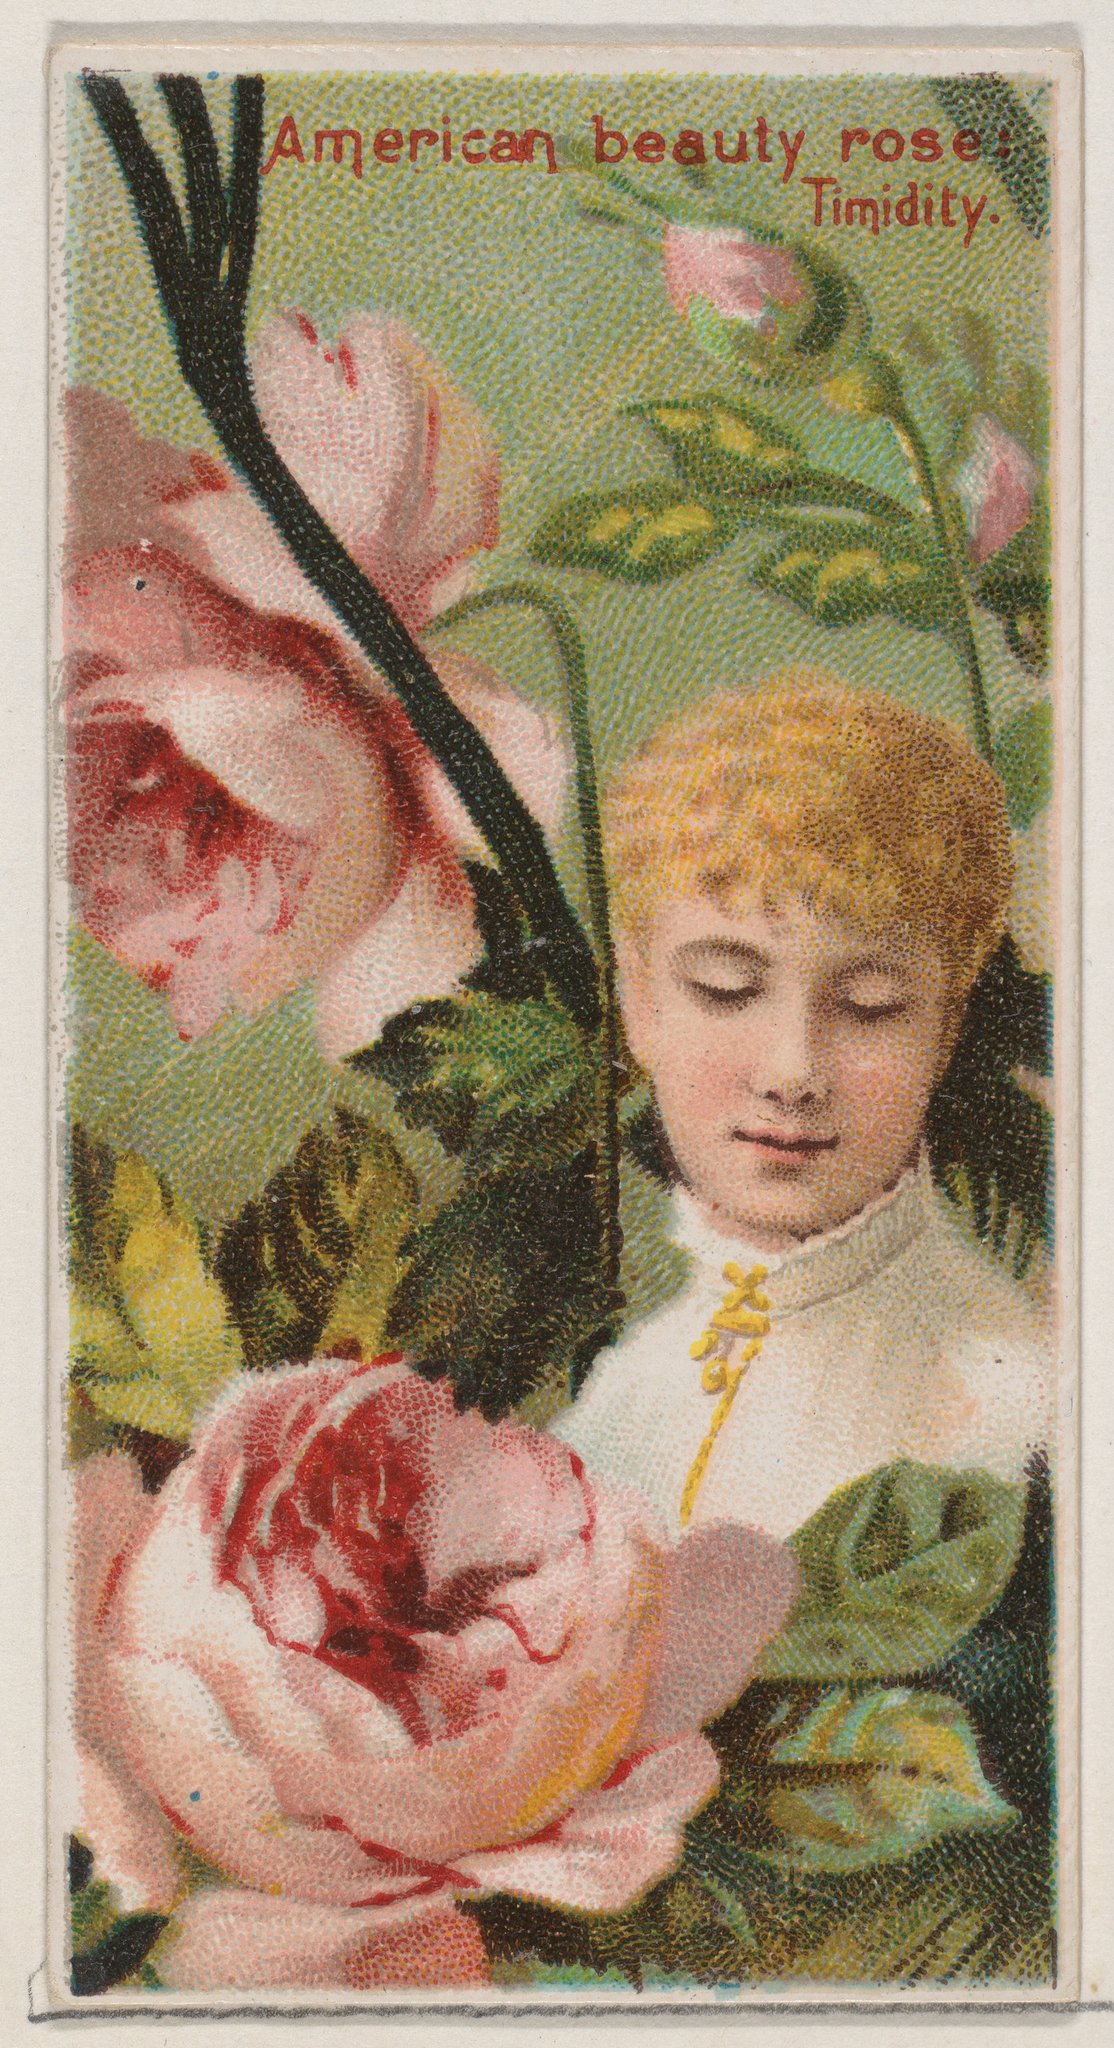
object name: print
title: American Beauty Rose: Timidity, from the series Floral Beauties and Language of Flowers (N75) for Duke brand cigarettes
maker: american tobacco company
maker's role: publisher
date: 1892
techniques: color lithograph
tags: women,roses